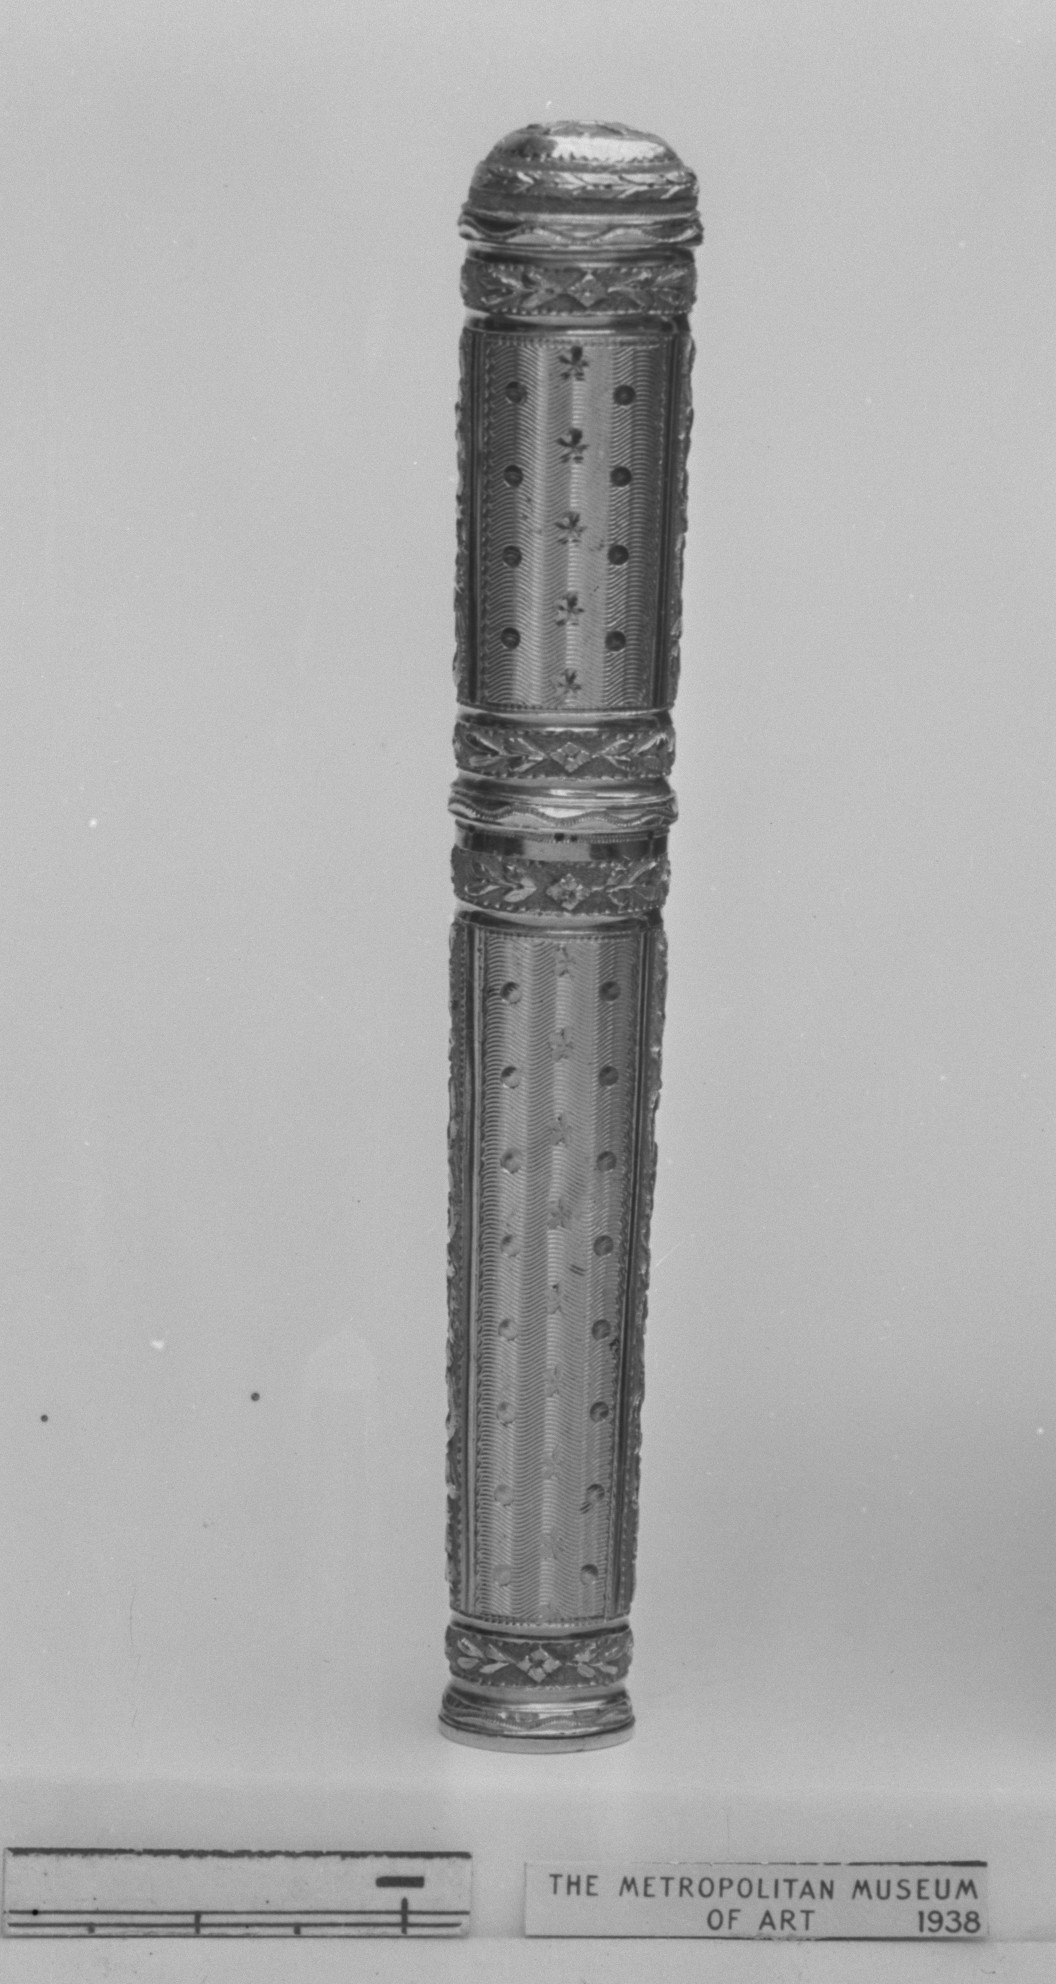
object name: étui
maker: etienne pierre rousselet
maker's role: artist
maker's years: 1758-1836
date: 1789-1790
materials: gold